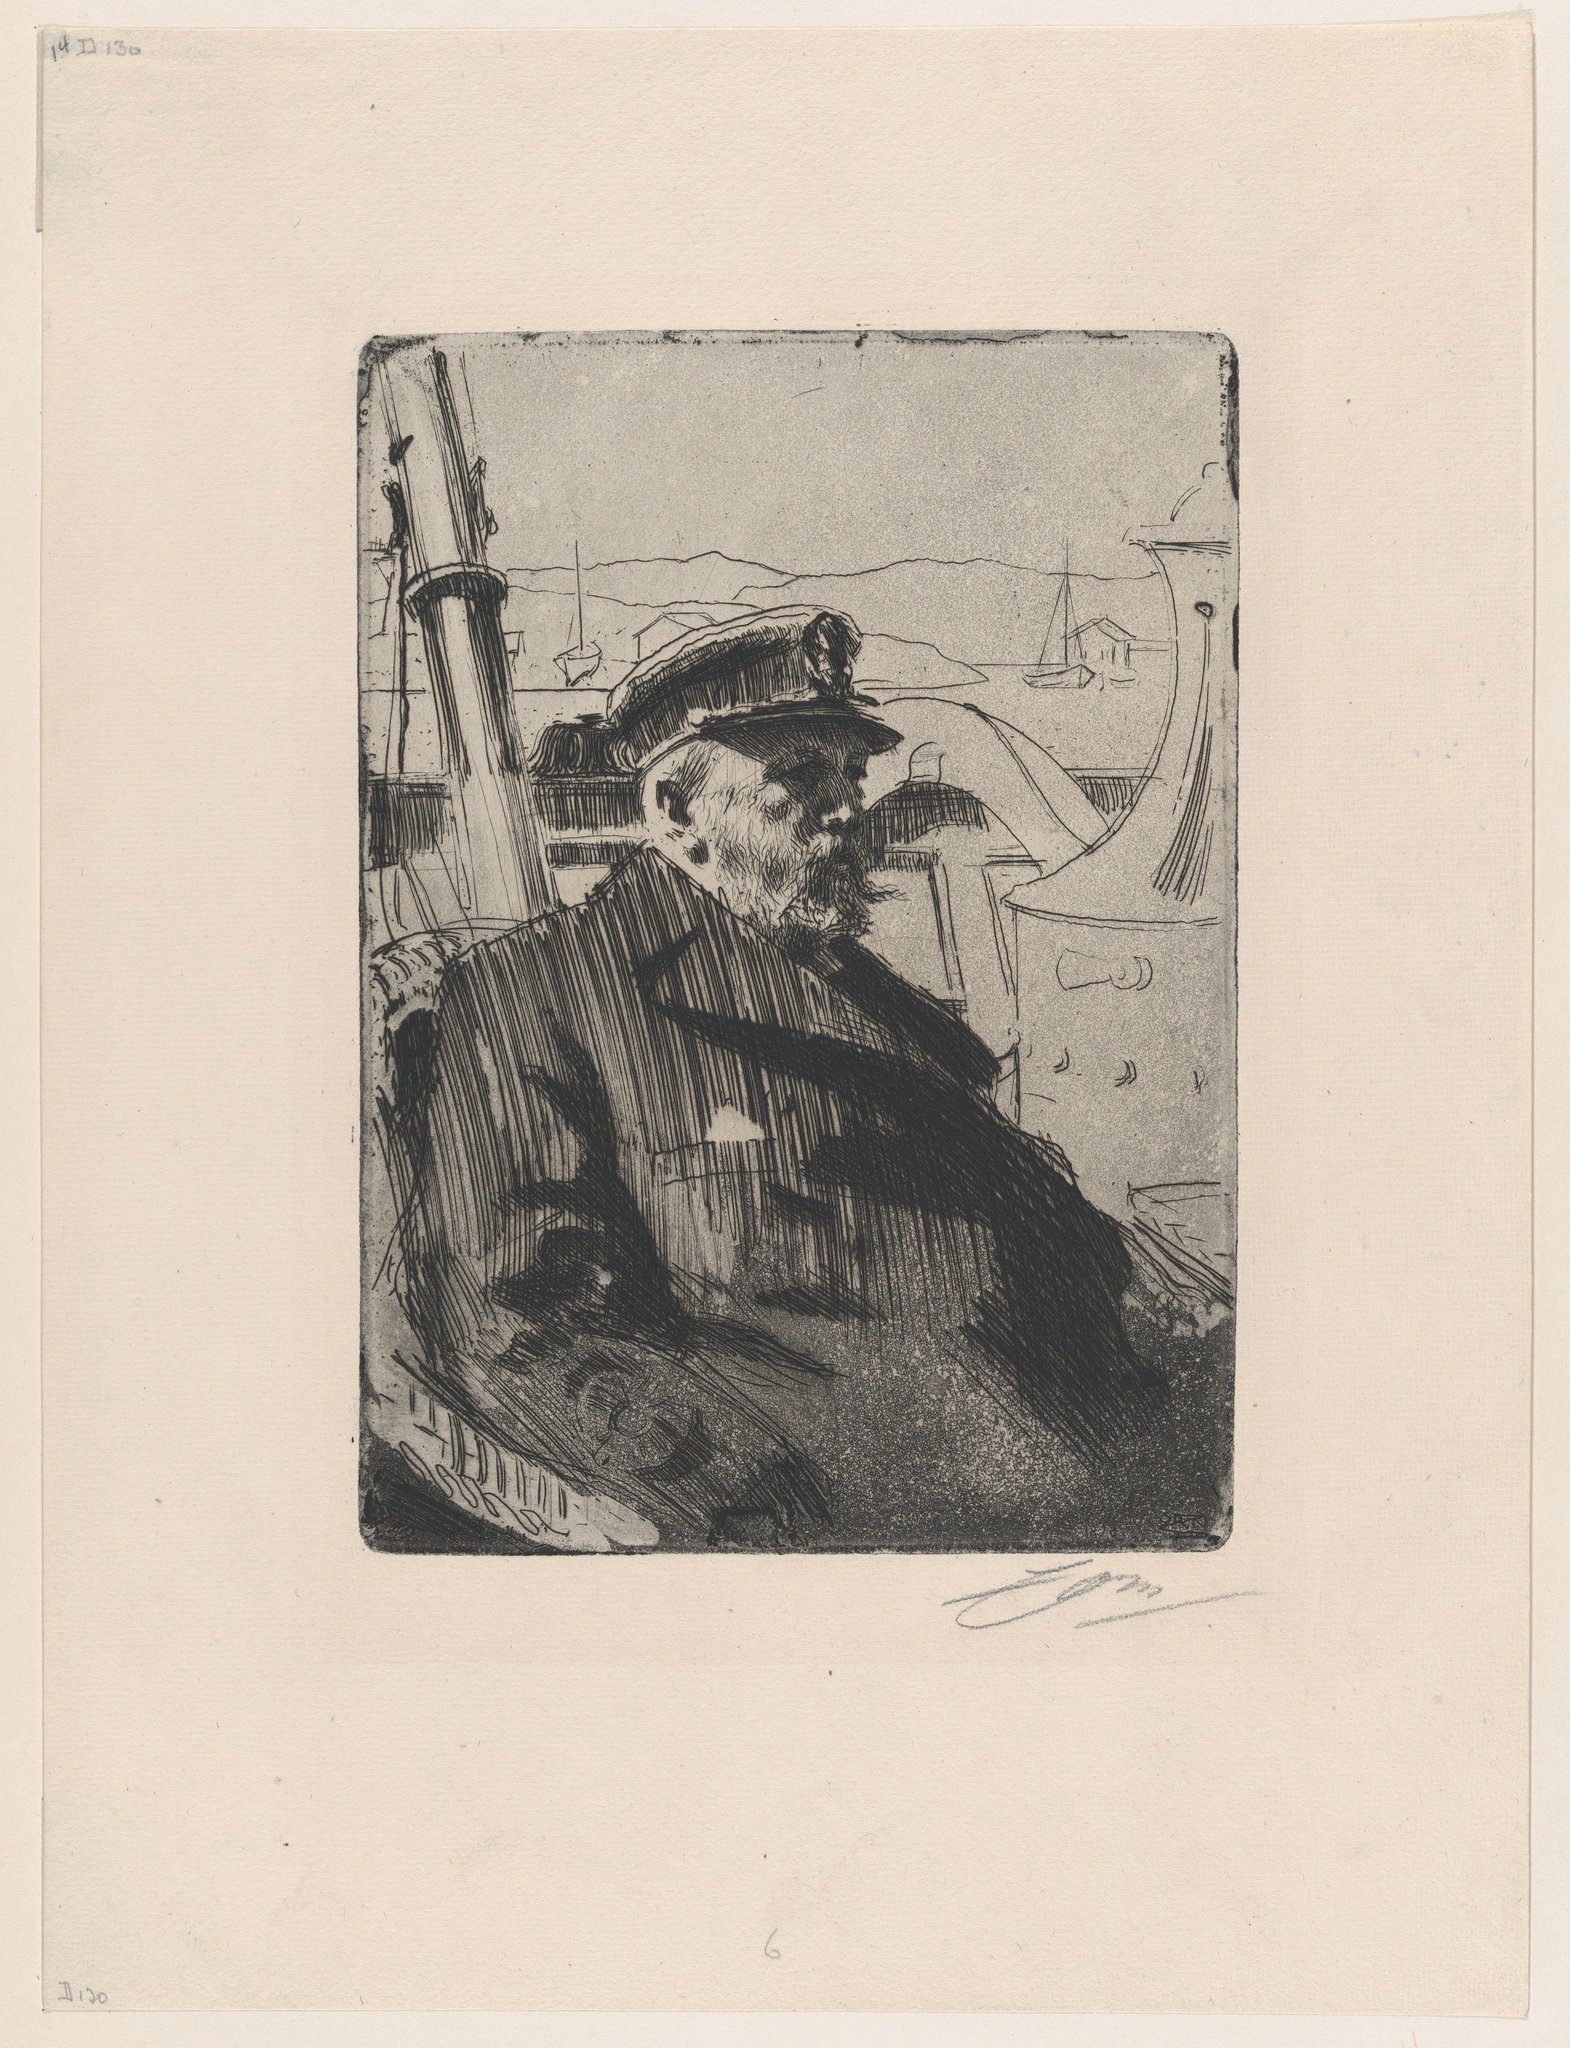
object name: print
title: King Oscar II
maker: anders zorn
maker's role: artist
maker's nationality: swedish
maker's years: 1860-1920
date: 1898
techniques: aquatint, etching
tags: kings